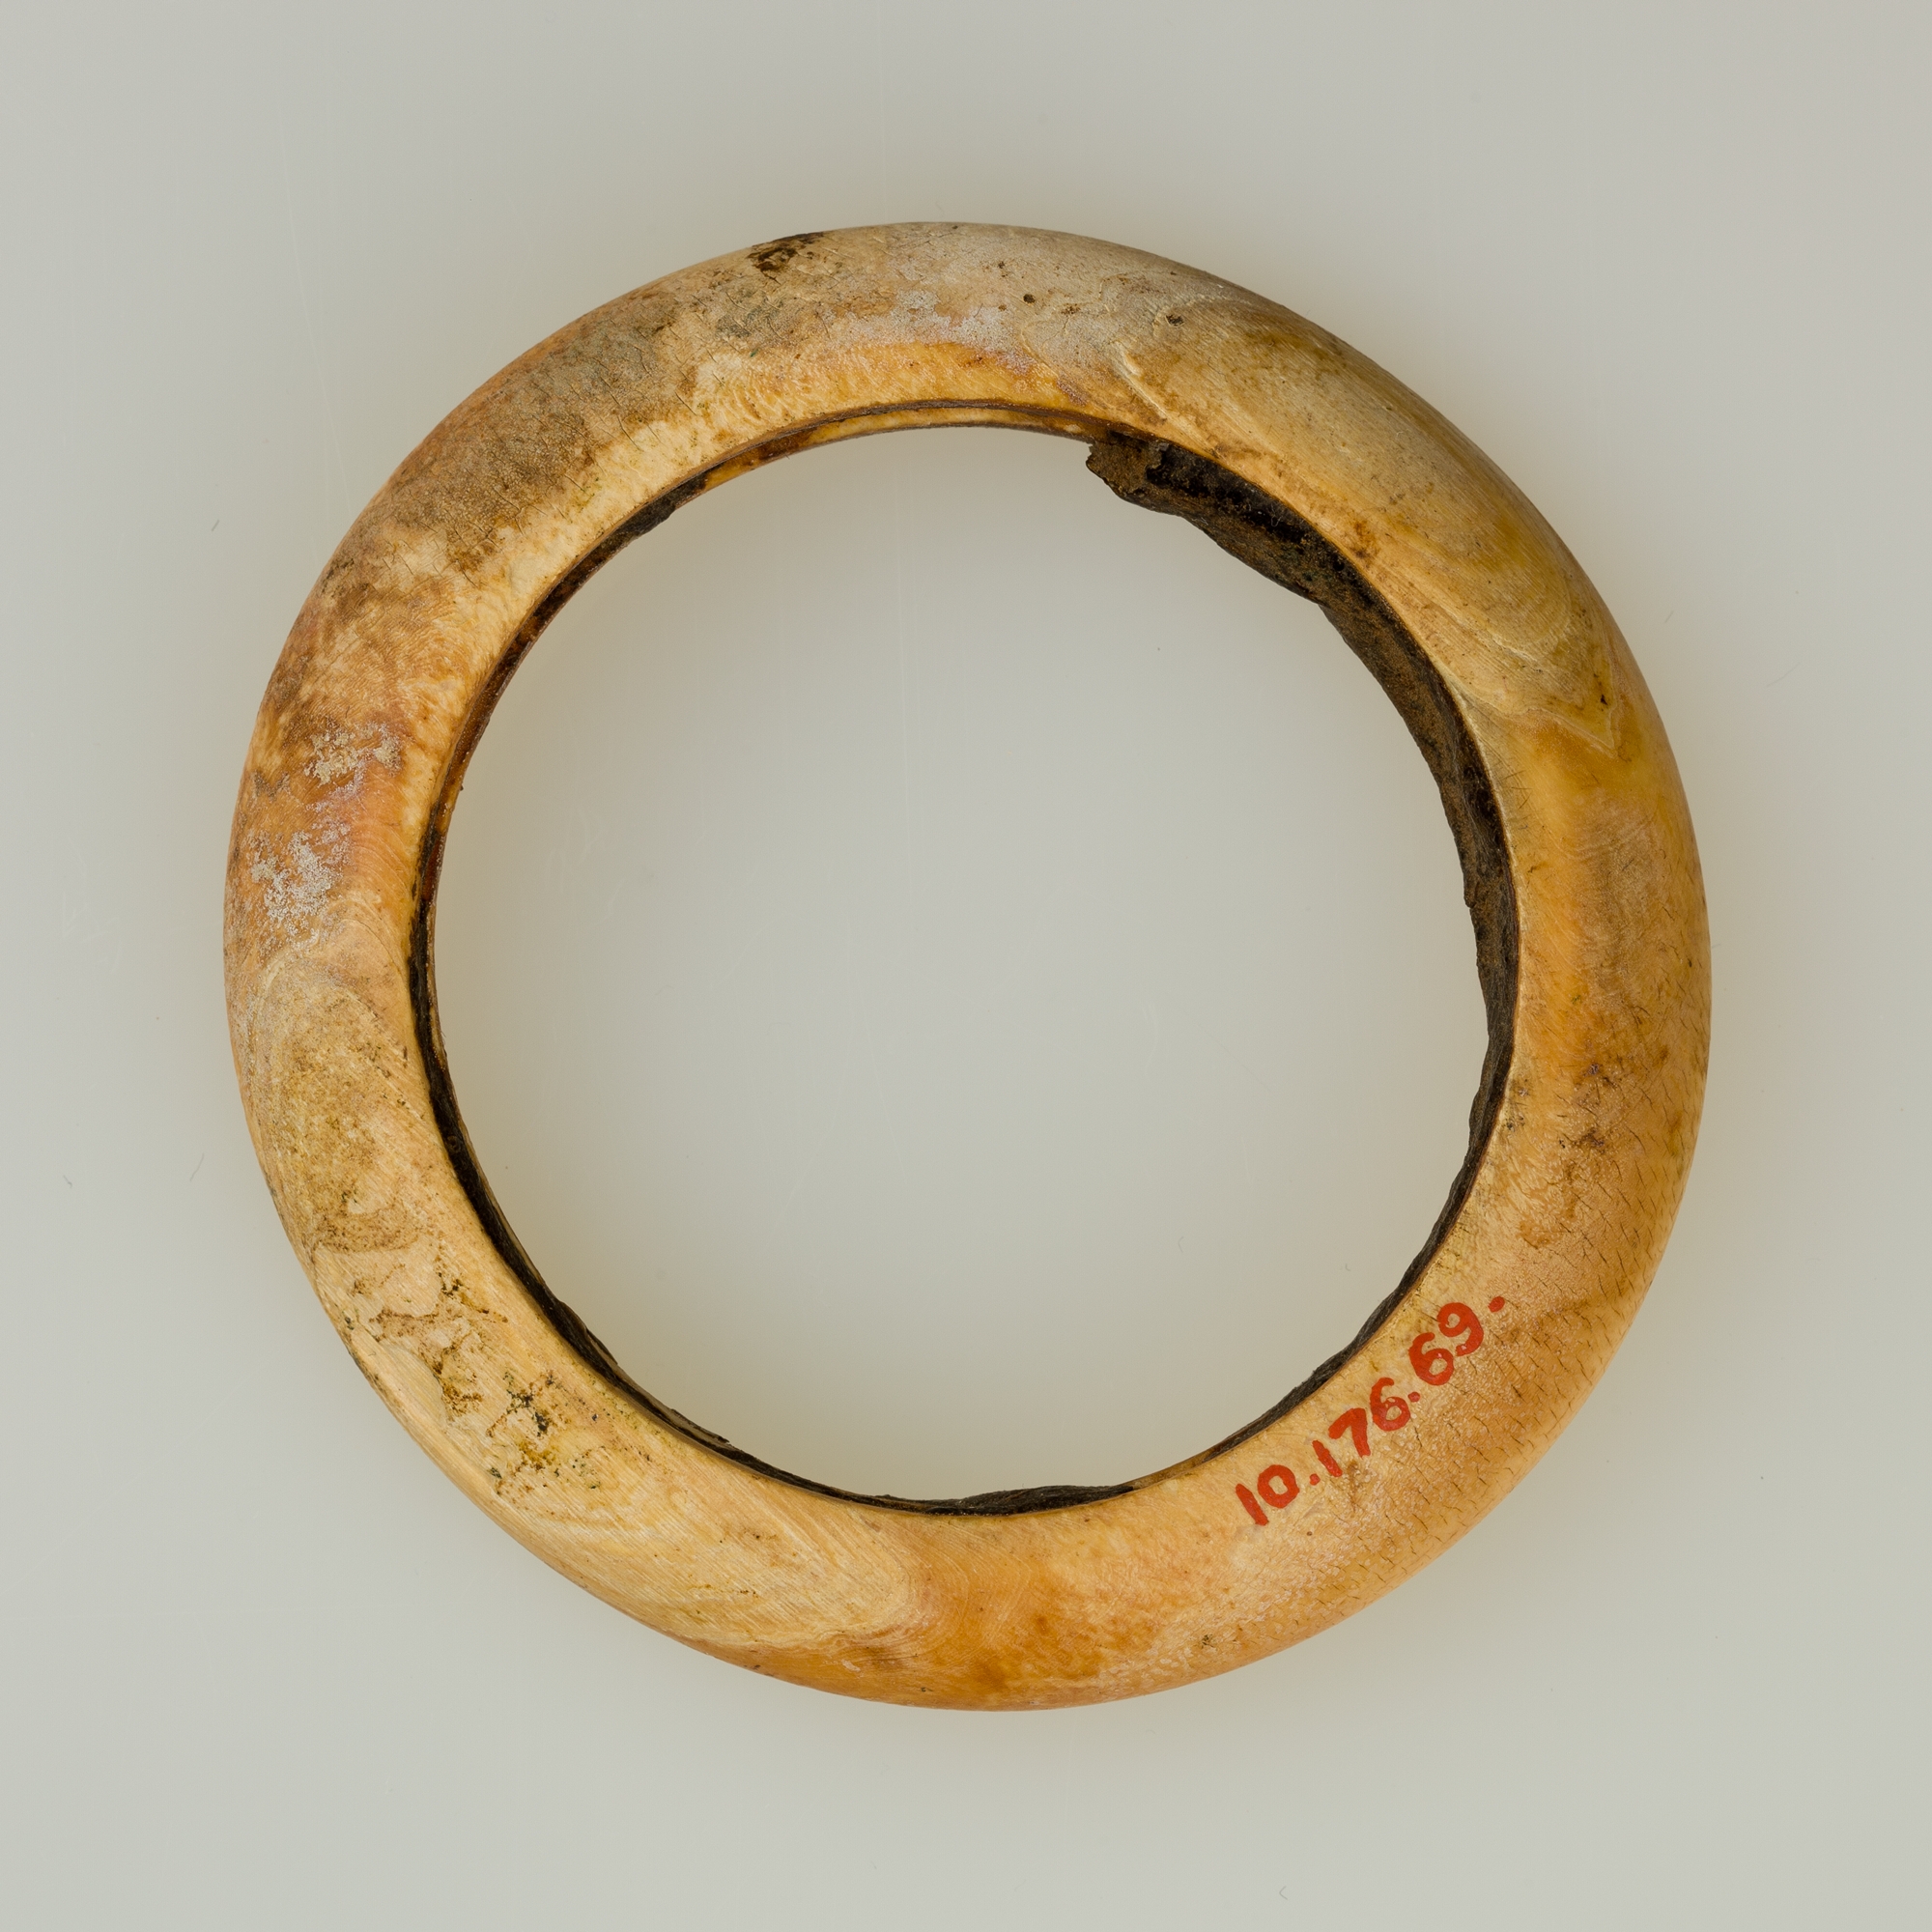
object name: bracelet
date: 3850-2960 BCE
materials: ivory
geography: egypt